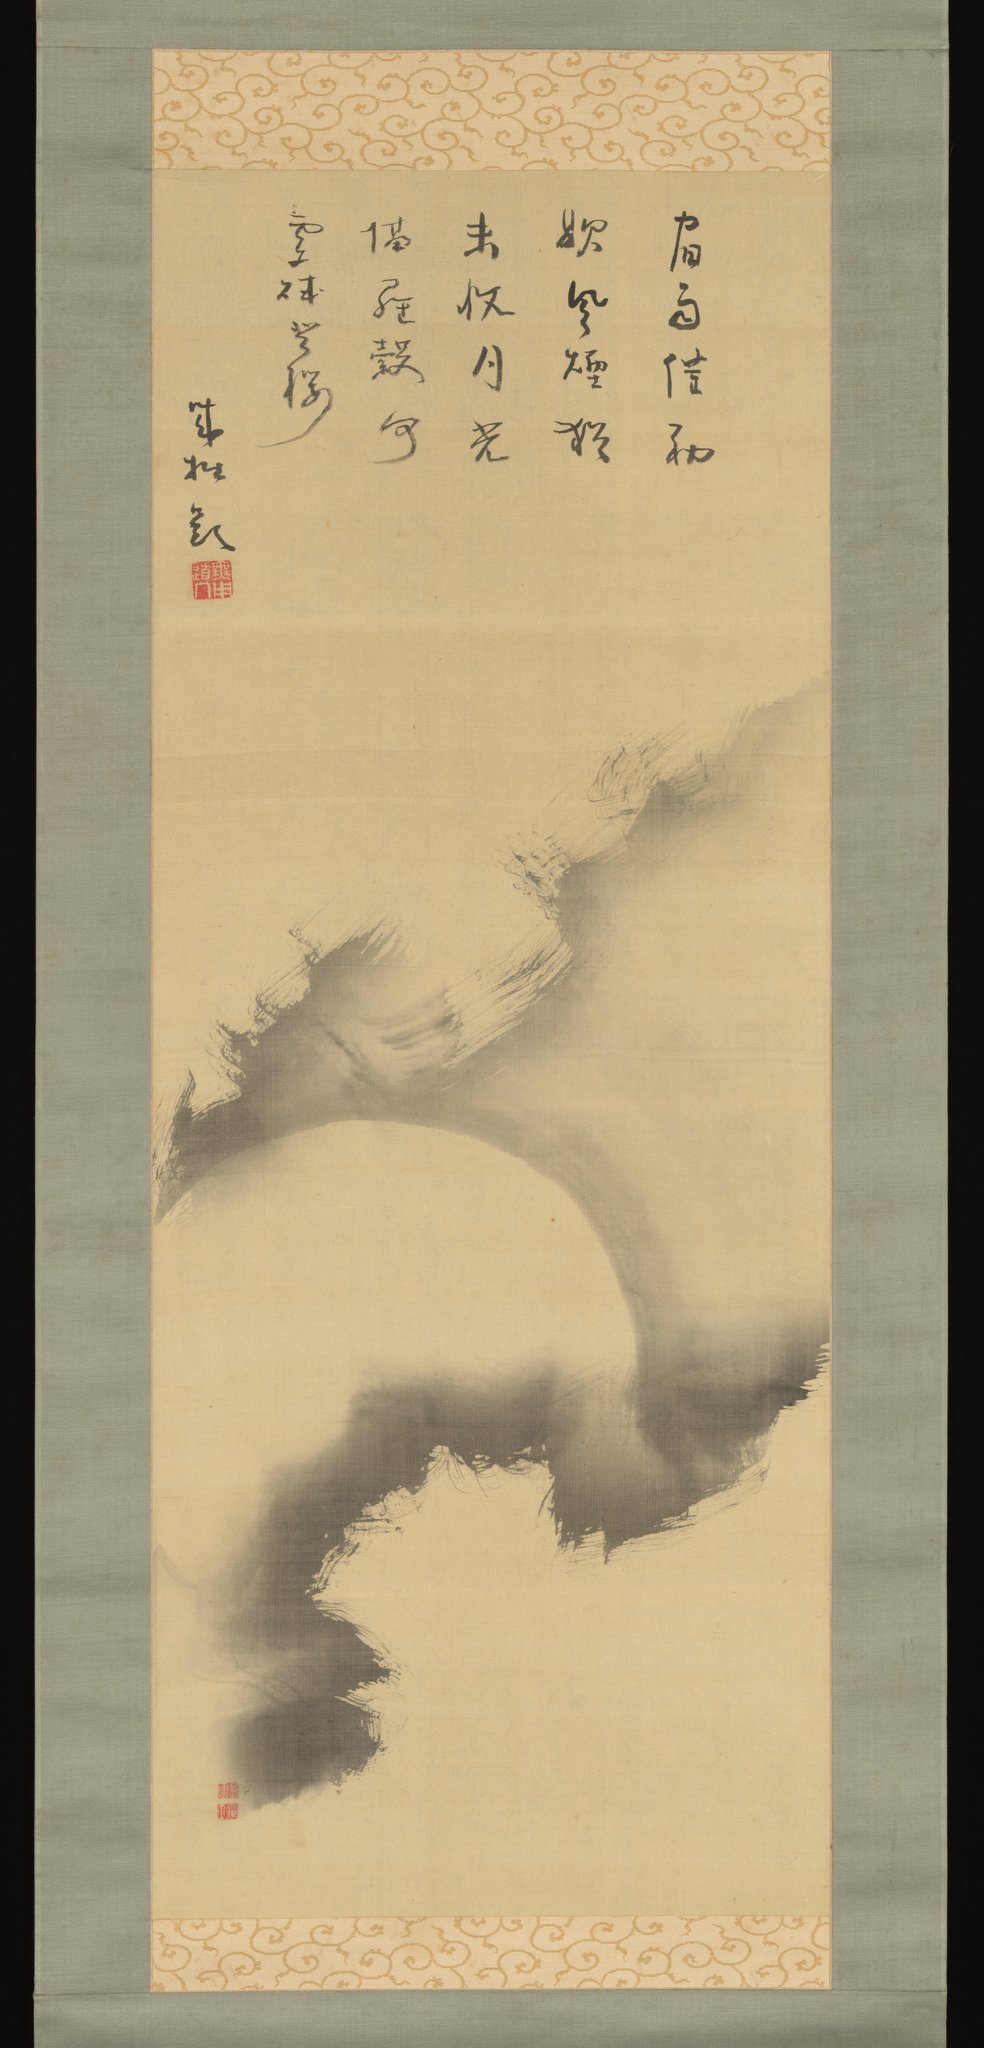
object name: hanging scroll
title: Moon amid Clouds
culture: japanese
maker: seisetsu shūcho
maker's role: artist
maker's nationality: japanese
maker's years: 1745-1820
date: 1801-1833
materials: ink, paper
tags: moon